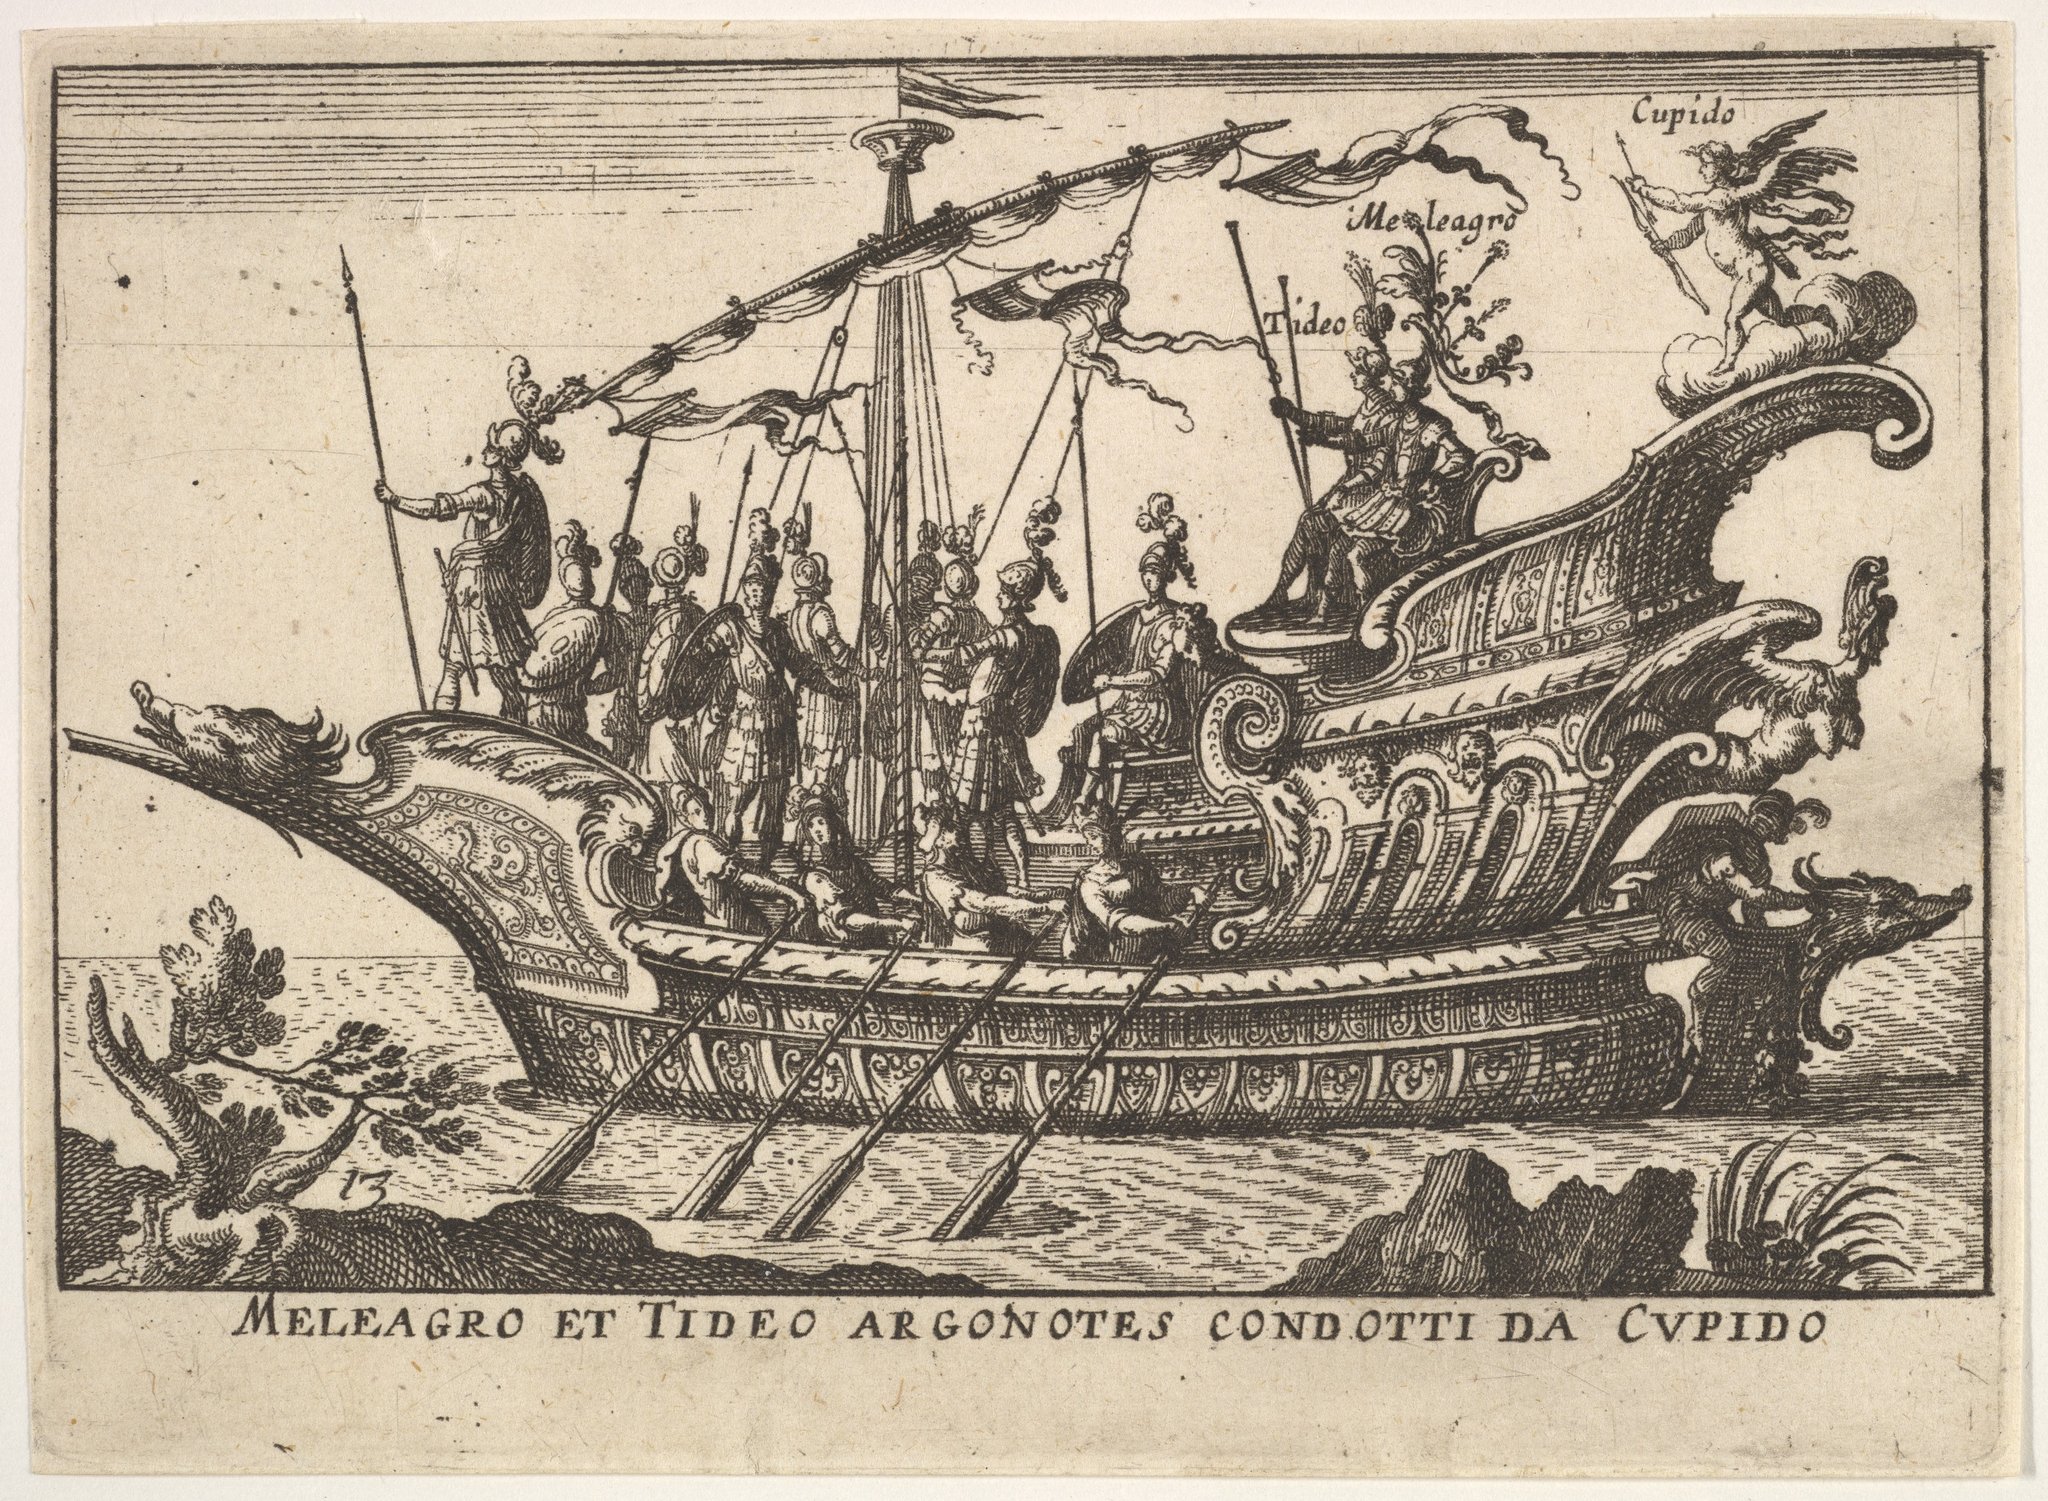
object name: print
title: Plate 13: Argonauts Meleager and Tydeus led by Cupid (Meleagro et Tideo Argonotes condotti da Cupido), from "The magnificent pageant on the river Arno in Florence for the marriage of the Grand Duke" (Le Magnifique carousel fait sur le fleuve de l'Arne a Florence, pour le mariage du Grand Duc)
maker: Anonymous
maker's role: artist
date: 1664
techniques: etching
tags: soldiers,men,cupid,ships